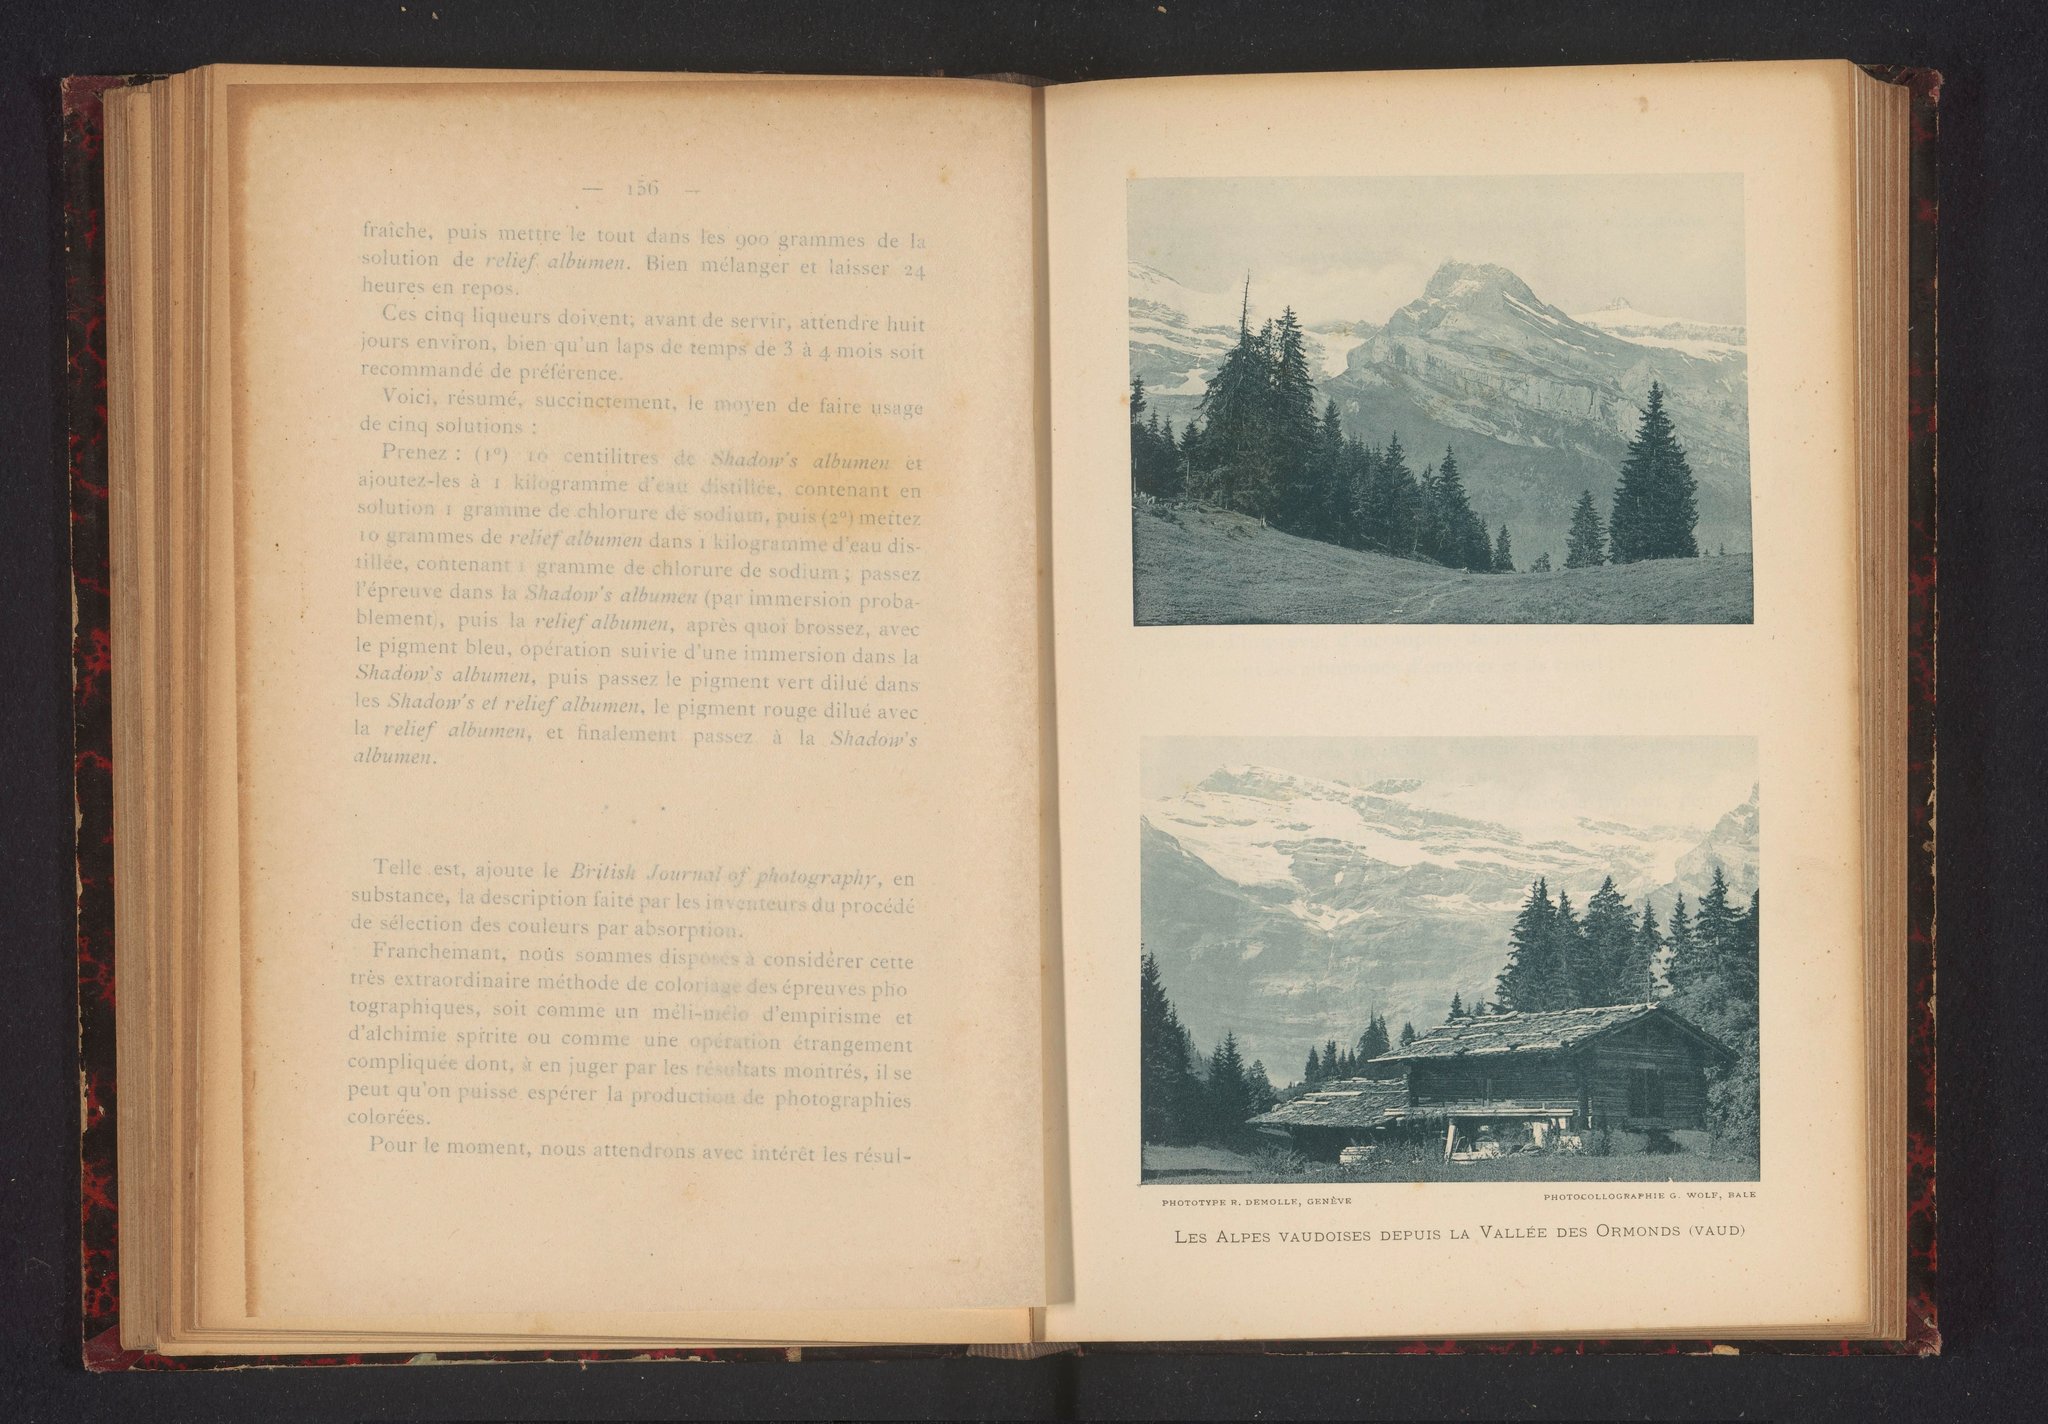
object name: page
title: Les Alpes vaudoises depuis la Vallée des Ormonds (vaud)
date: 1892-1897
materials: paper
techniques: photograph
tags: mountains